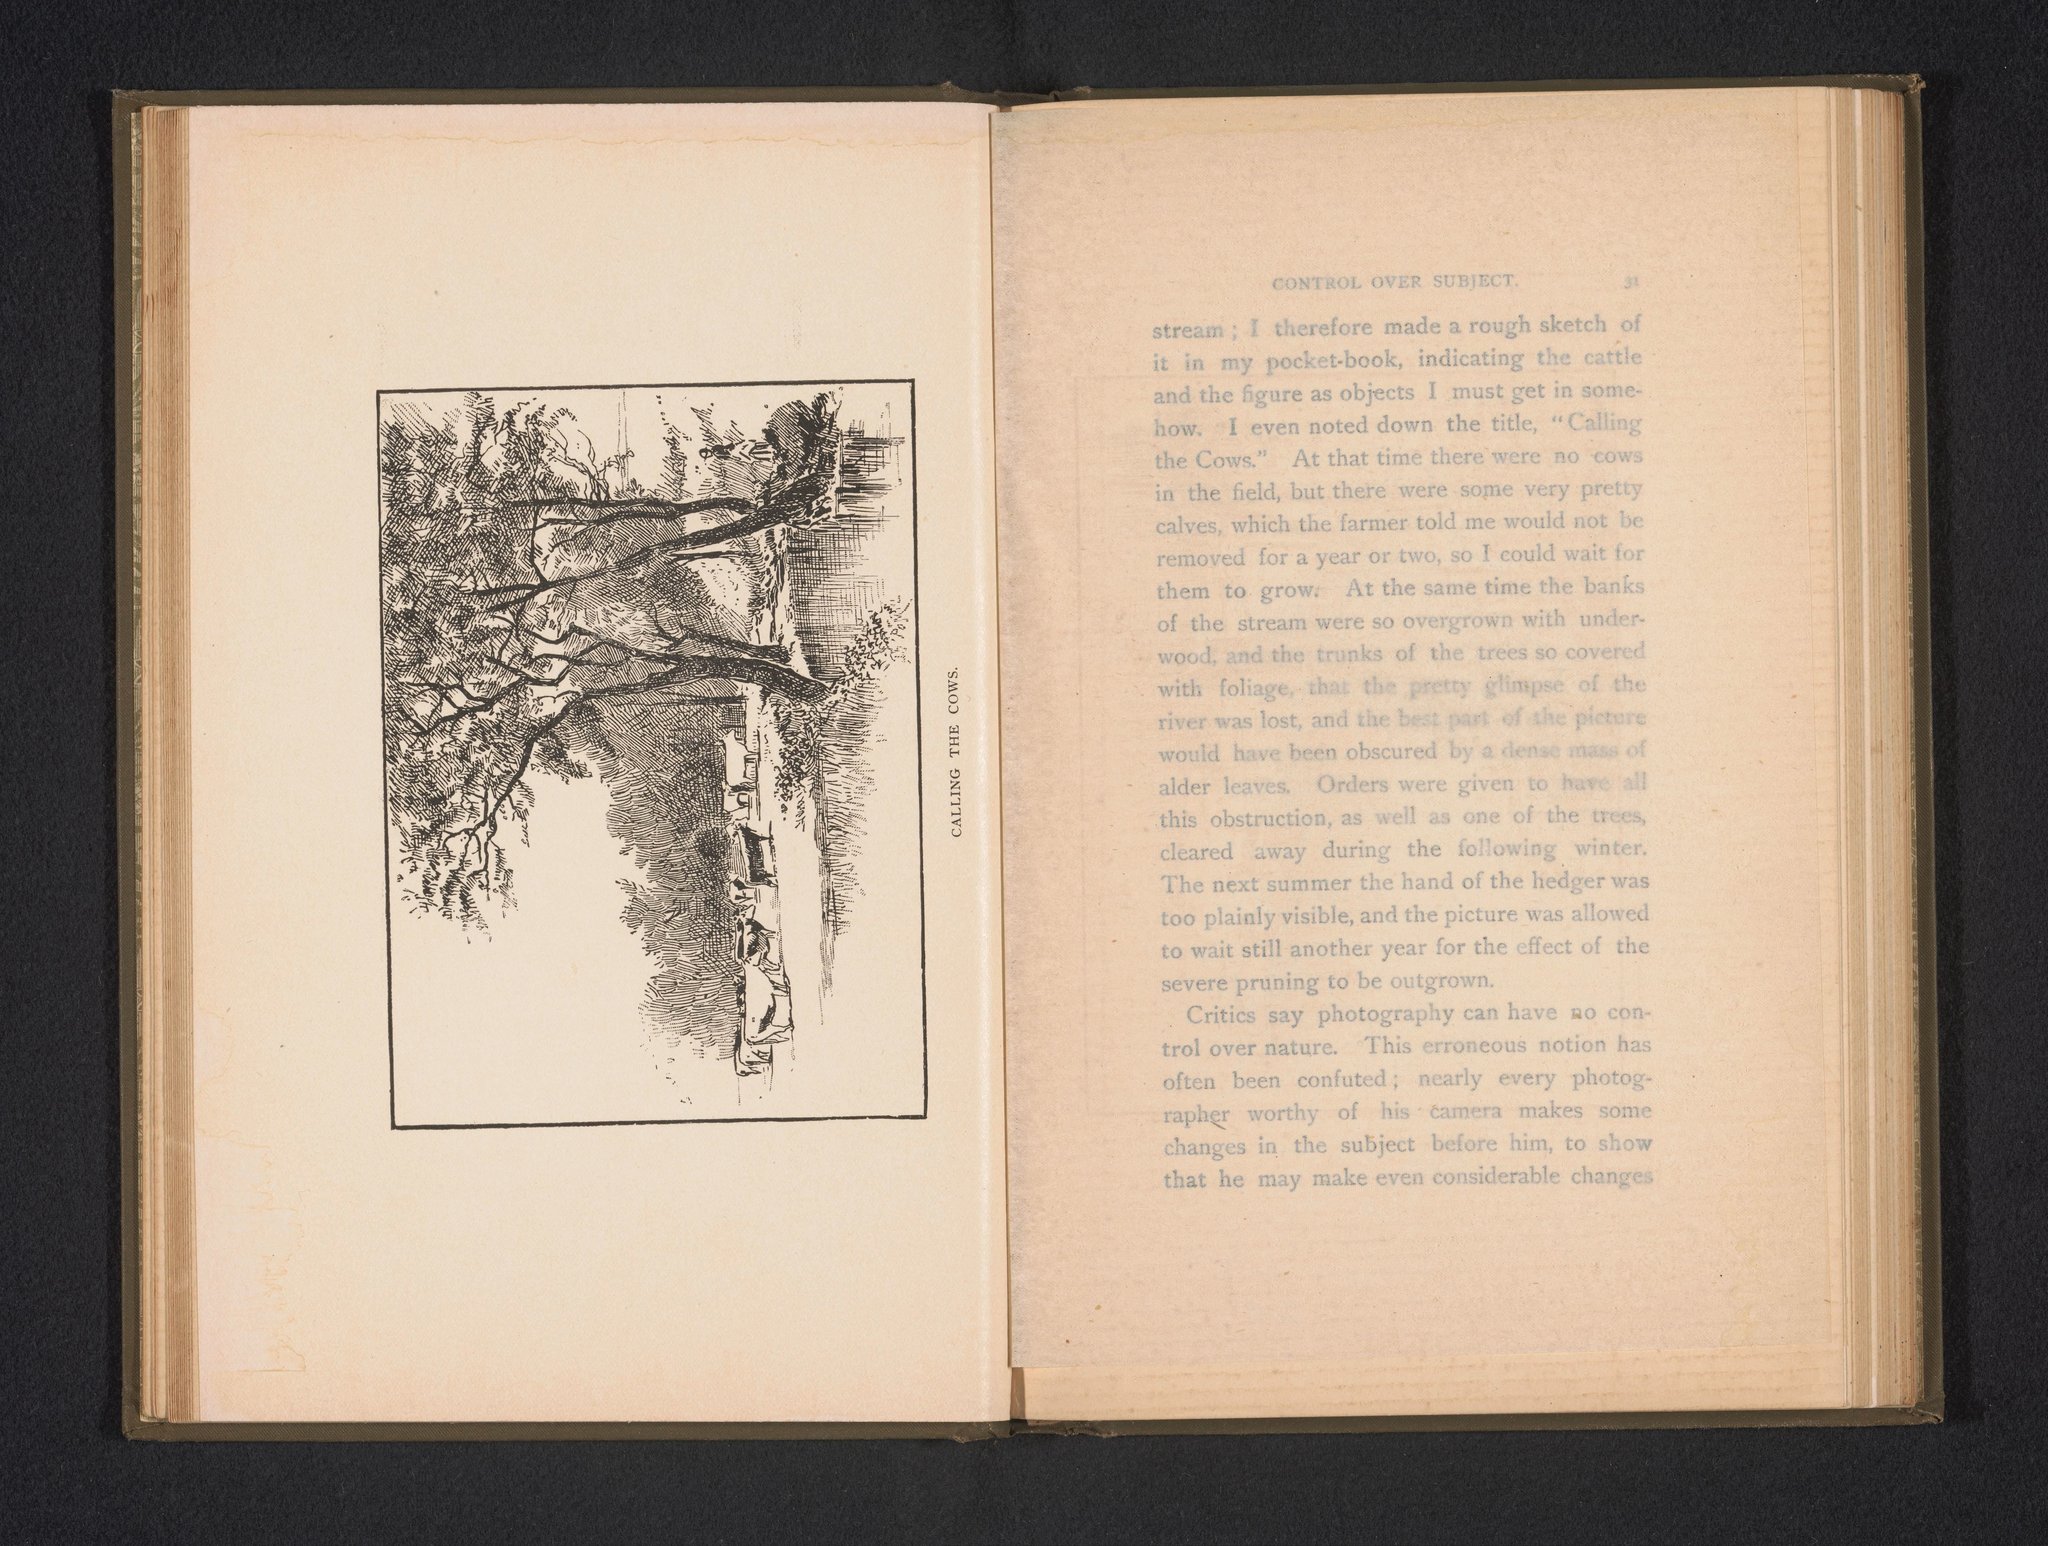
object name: reproduction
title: Fotoreproductie van een werk met een kudde koeien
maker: Anonymous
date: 1883-1888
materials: paper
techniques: autotype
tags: cow